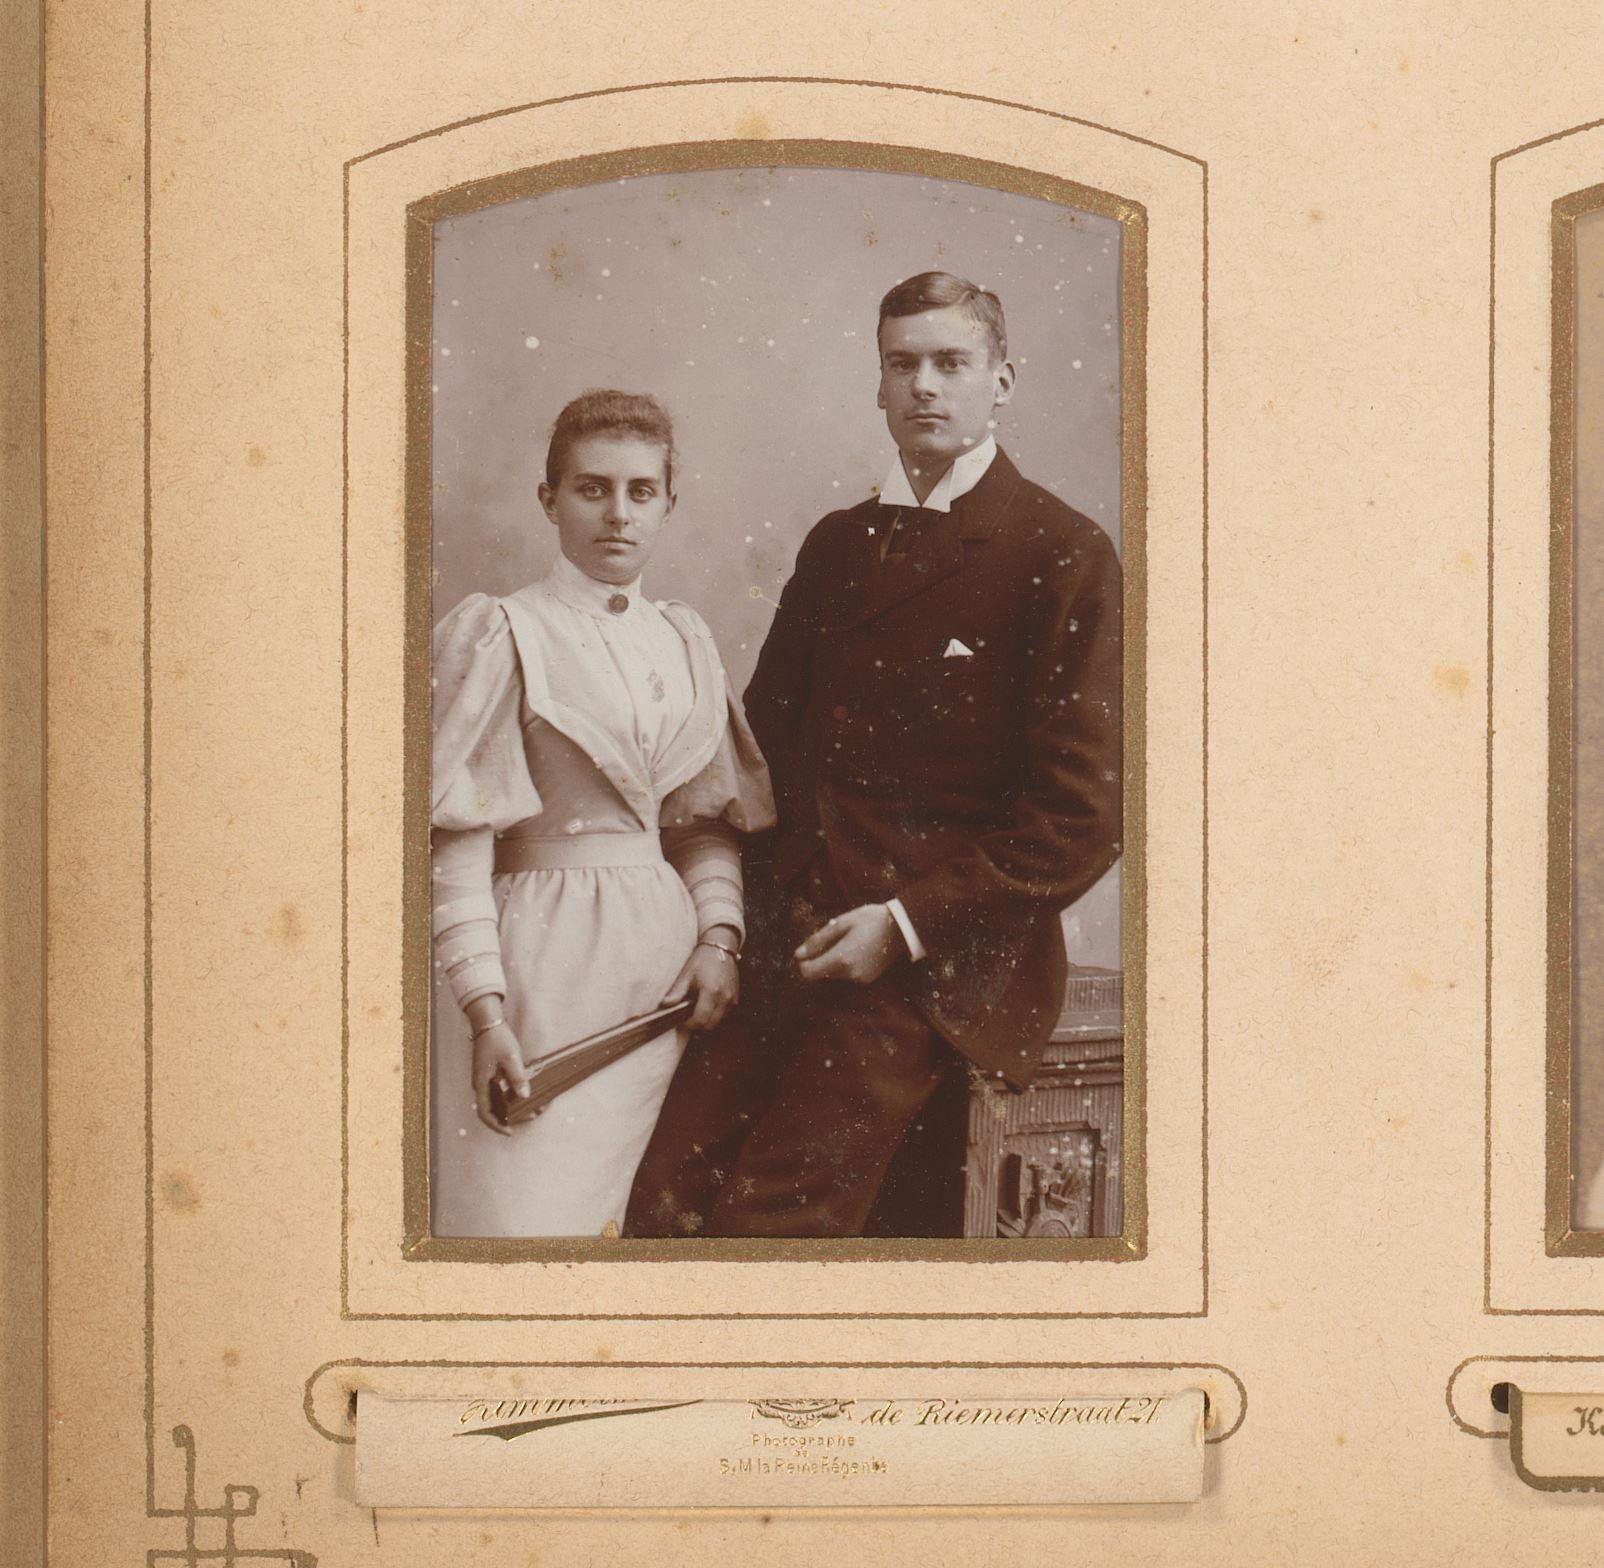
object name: album leaf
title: Portret van een jongeman en vrouw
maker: adolphe zimmermans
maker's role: fotograaf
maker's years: 1858-1922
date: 1884-1913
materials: cardboard, photographic support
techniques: collodion silver print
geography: the hague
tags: historical persons - bb - woman, historical persons, youth, adolescent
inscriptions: inscription: ‘Adolphe Zimmermans/ Photogr. de la Cour/ Anvers/ 1885/ De Riemerstraat 21/ La Haye’